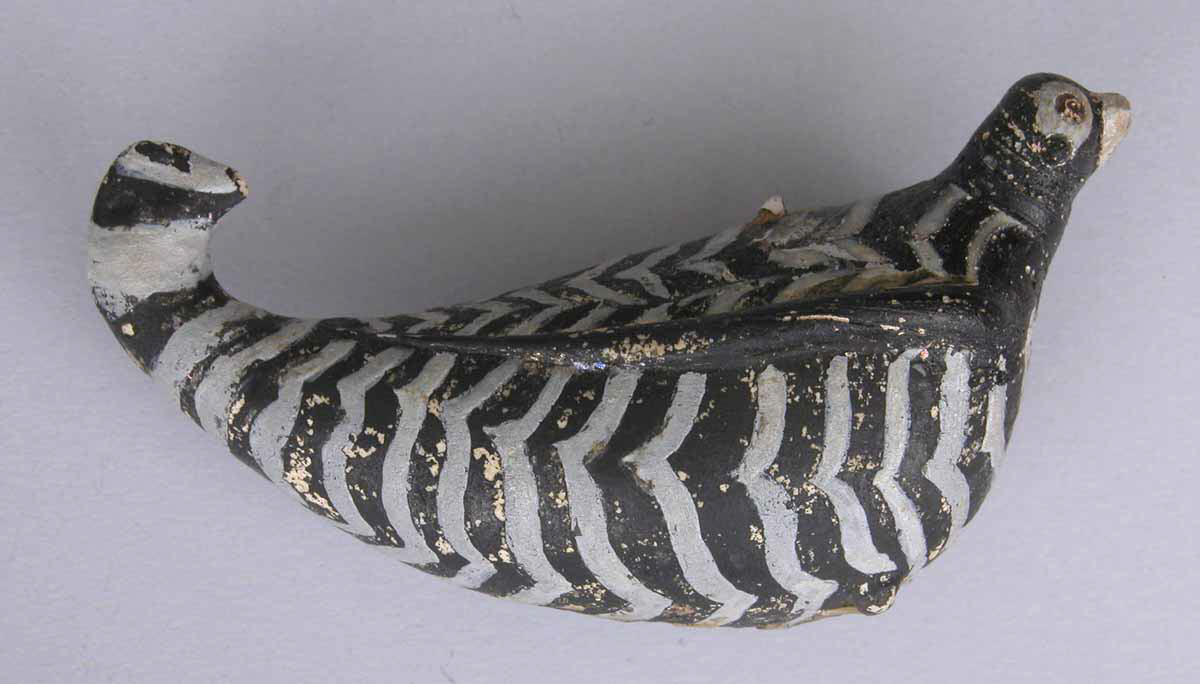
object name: figure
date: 701-900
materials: glass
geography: egypt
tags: birds